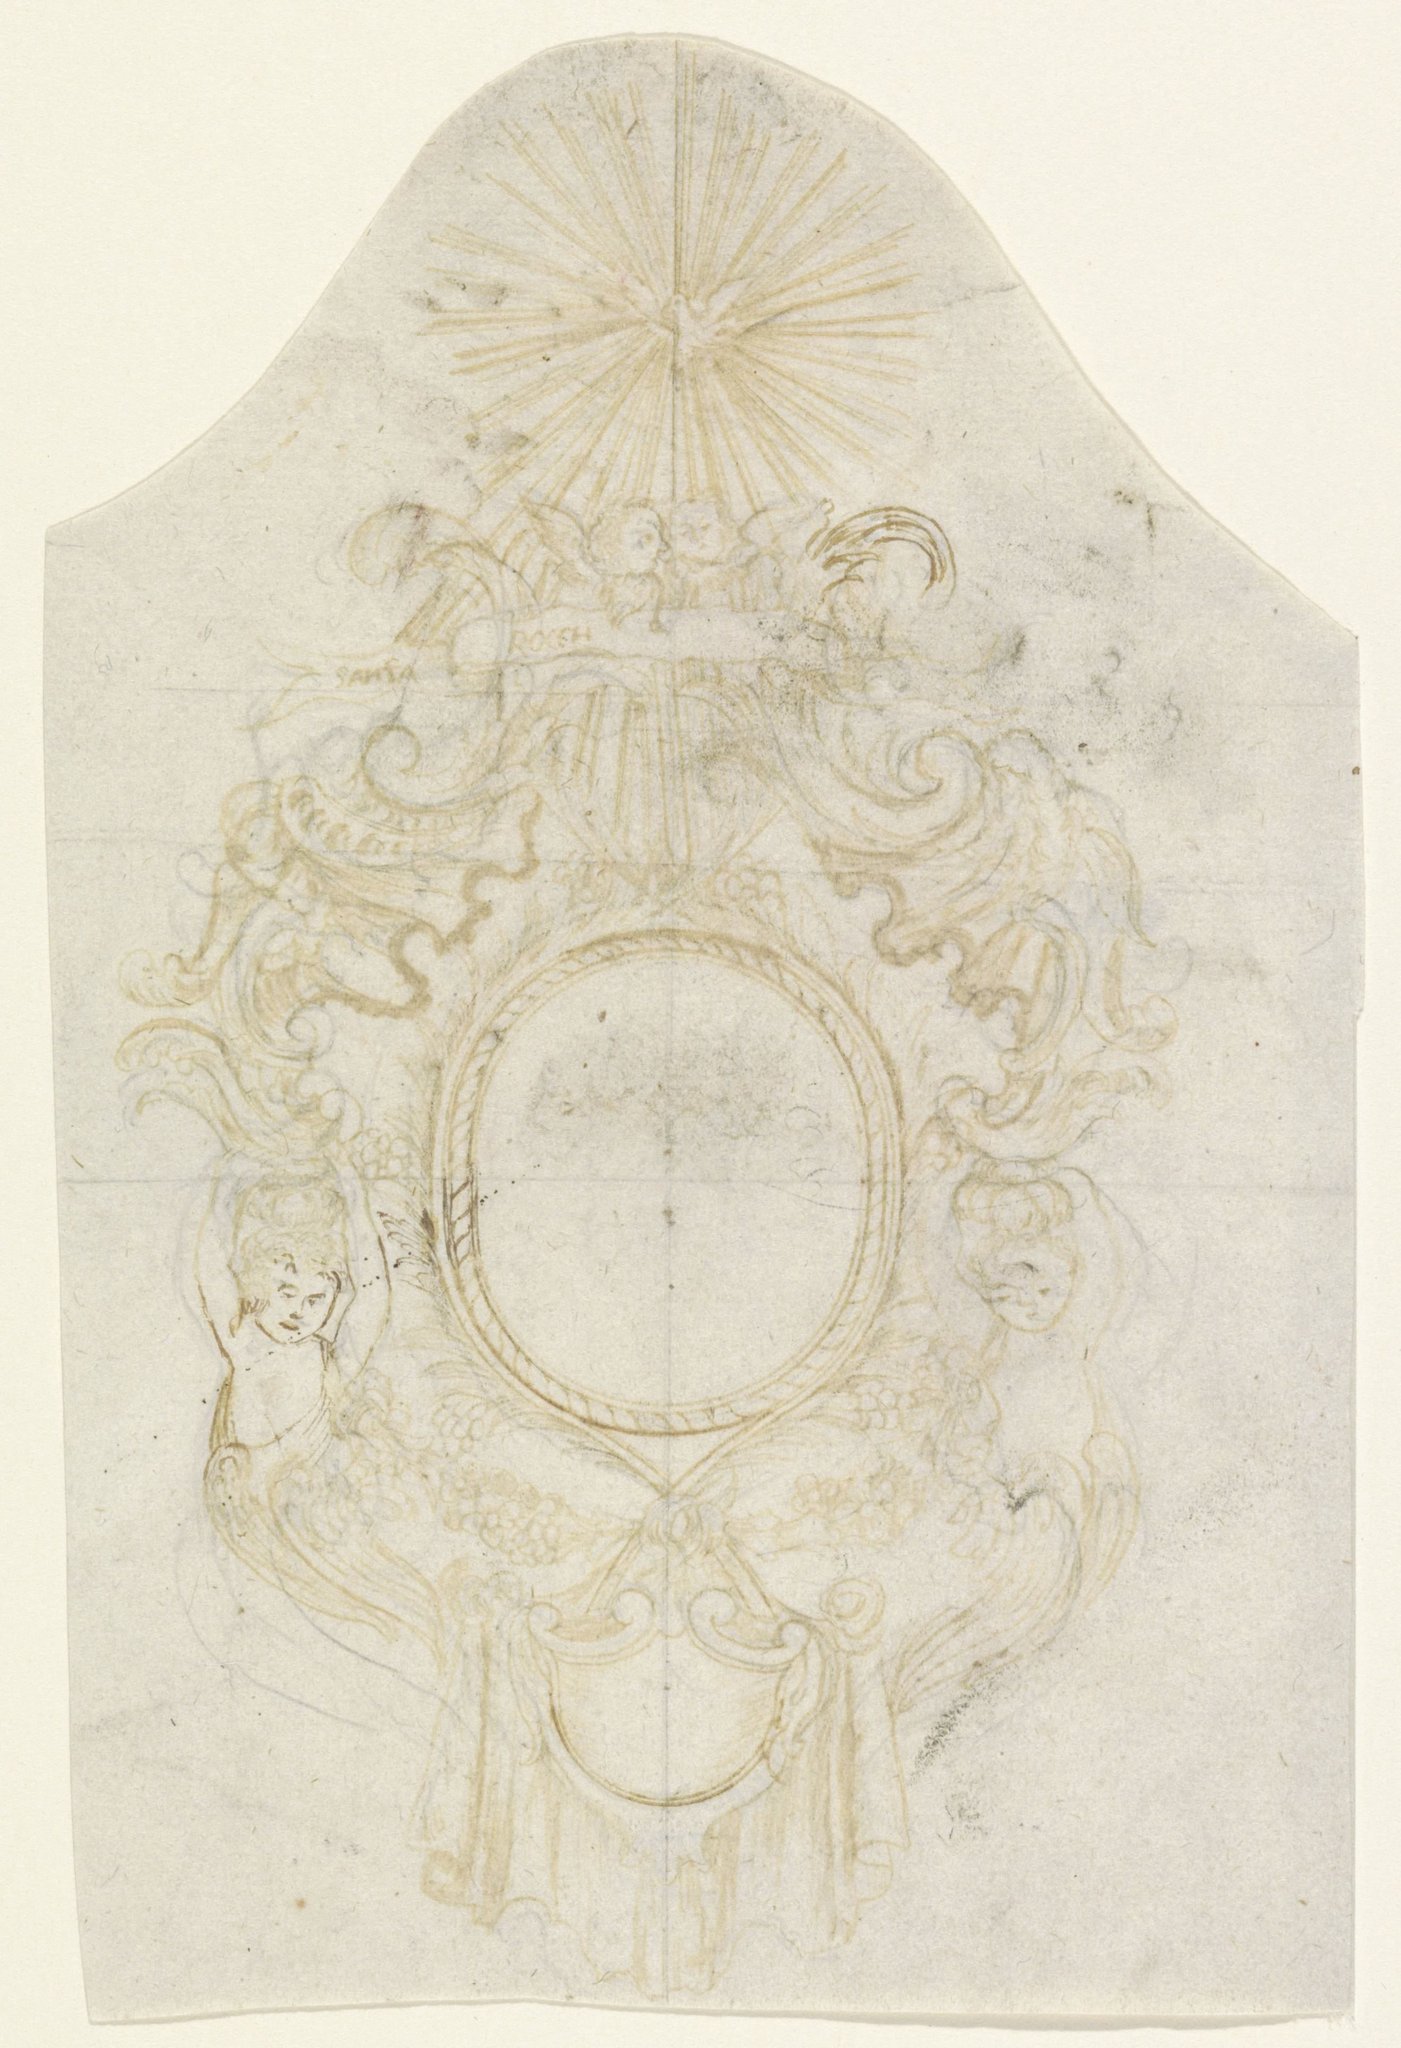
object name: drawing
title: Medaillon met putti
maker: Anonymous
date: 1700-1800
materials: ink, paper, pencil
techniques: pen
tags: ornament ~ medallion, cupids: 'amores', 'amoretti', 'putti'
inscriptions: collector's mark: Lugt 2228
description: Een ovaal medaillon met rocailles, putti en aan de bovenzijde een duif in stralenkrans als symbool van de Heilige Geest. Aan de onderzijde een wijwaterbak. Links boven een banderol met tekst Santa Rocsh.